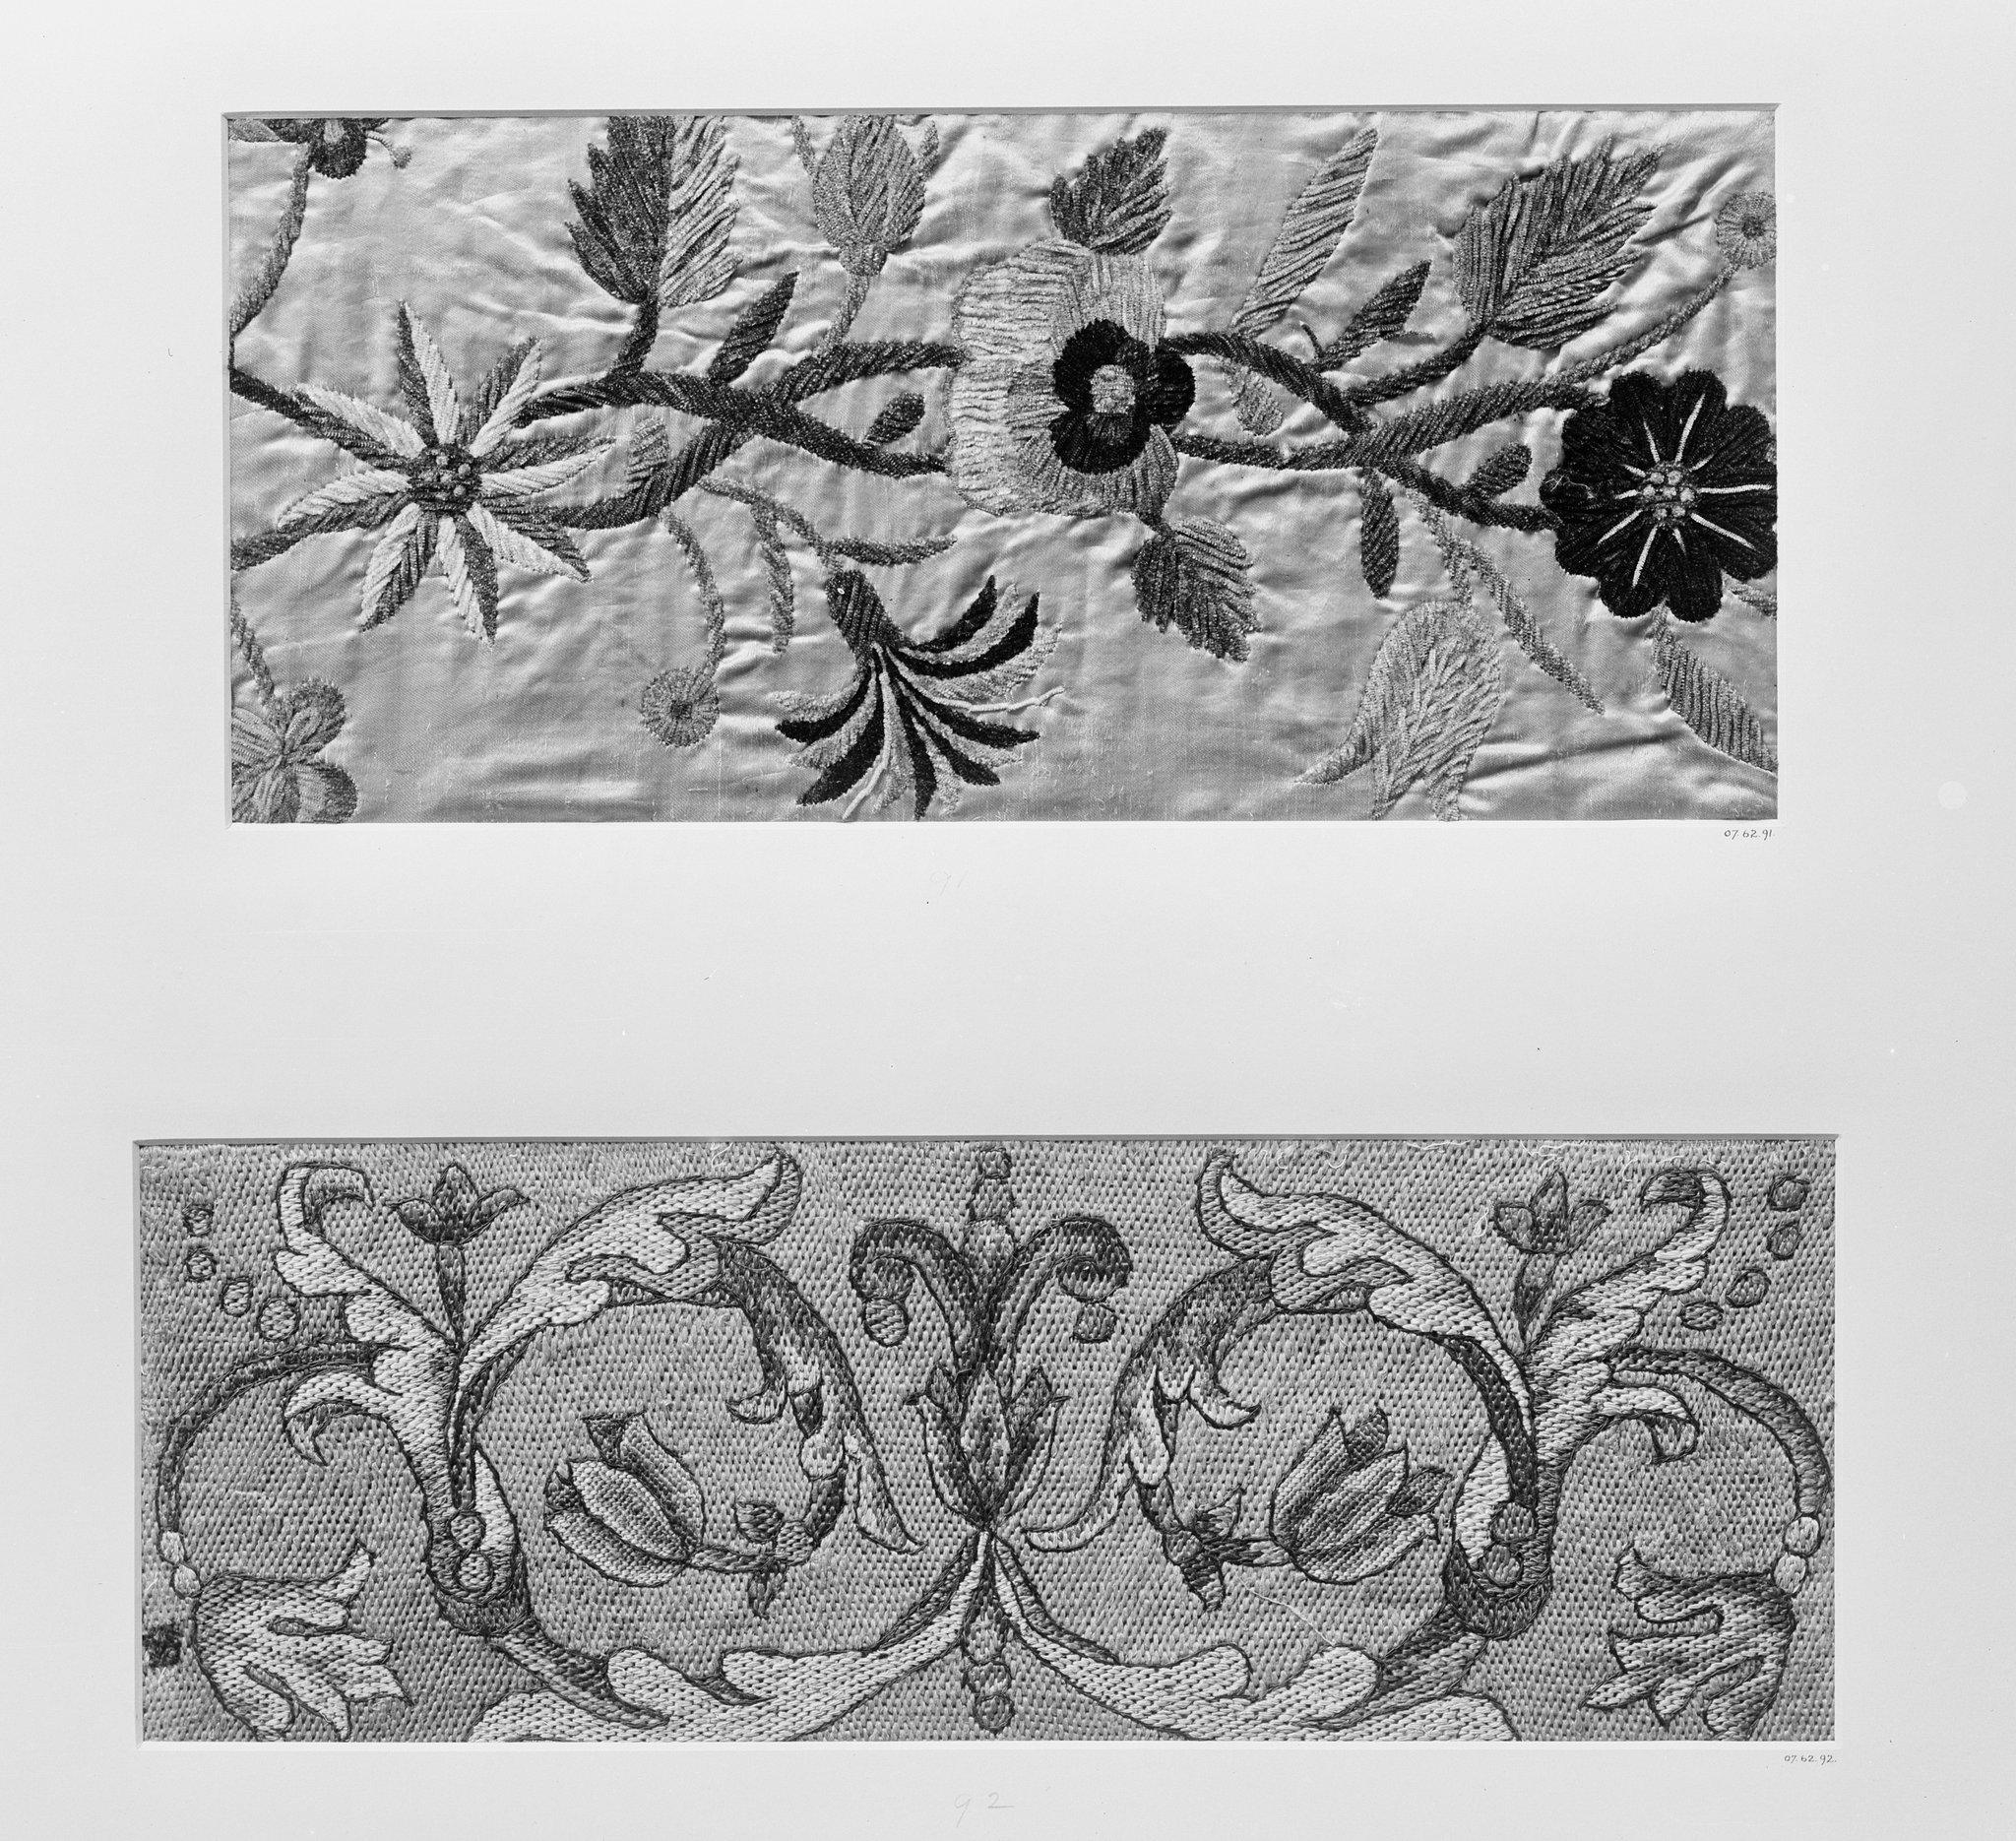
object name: fragment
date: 1601-1700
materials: canvas, silk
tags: flowers,leaves